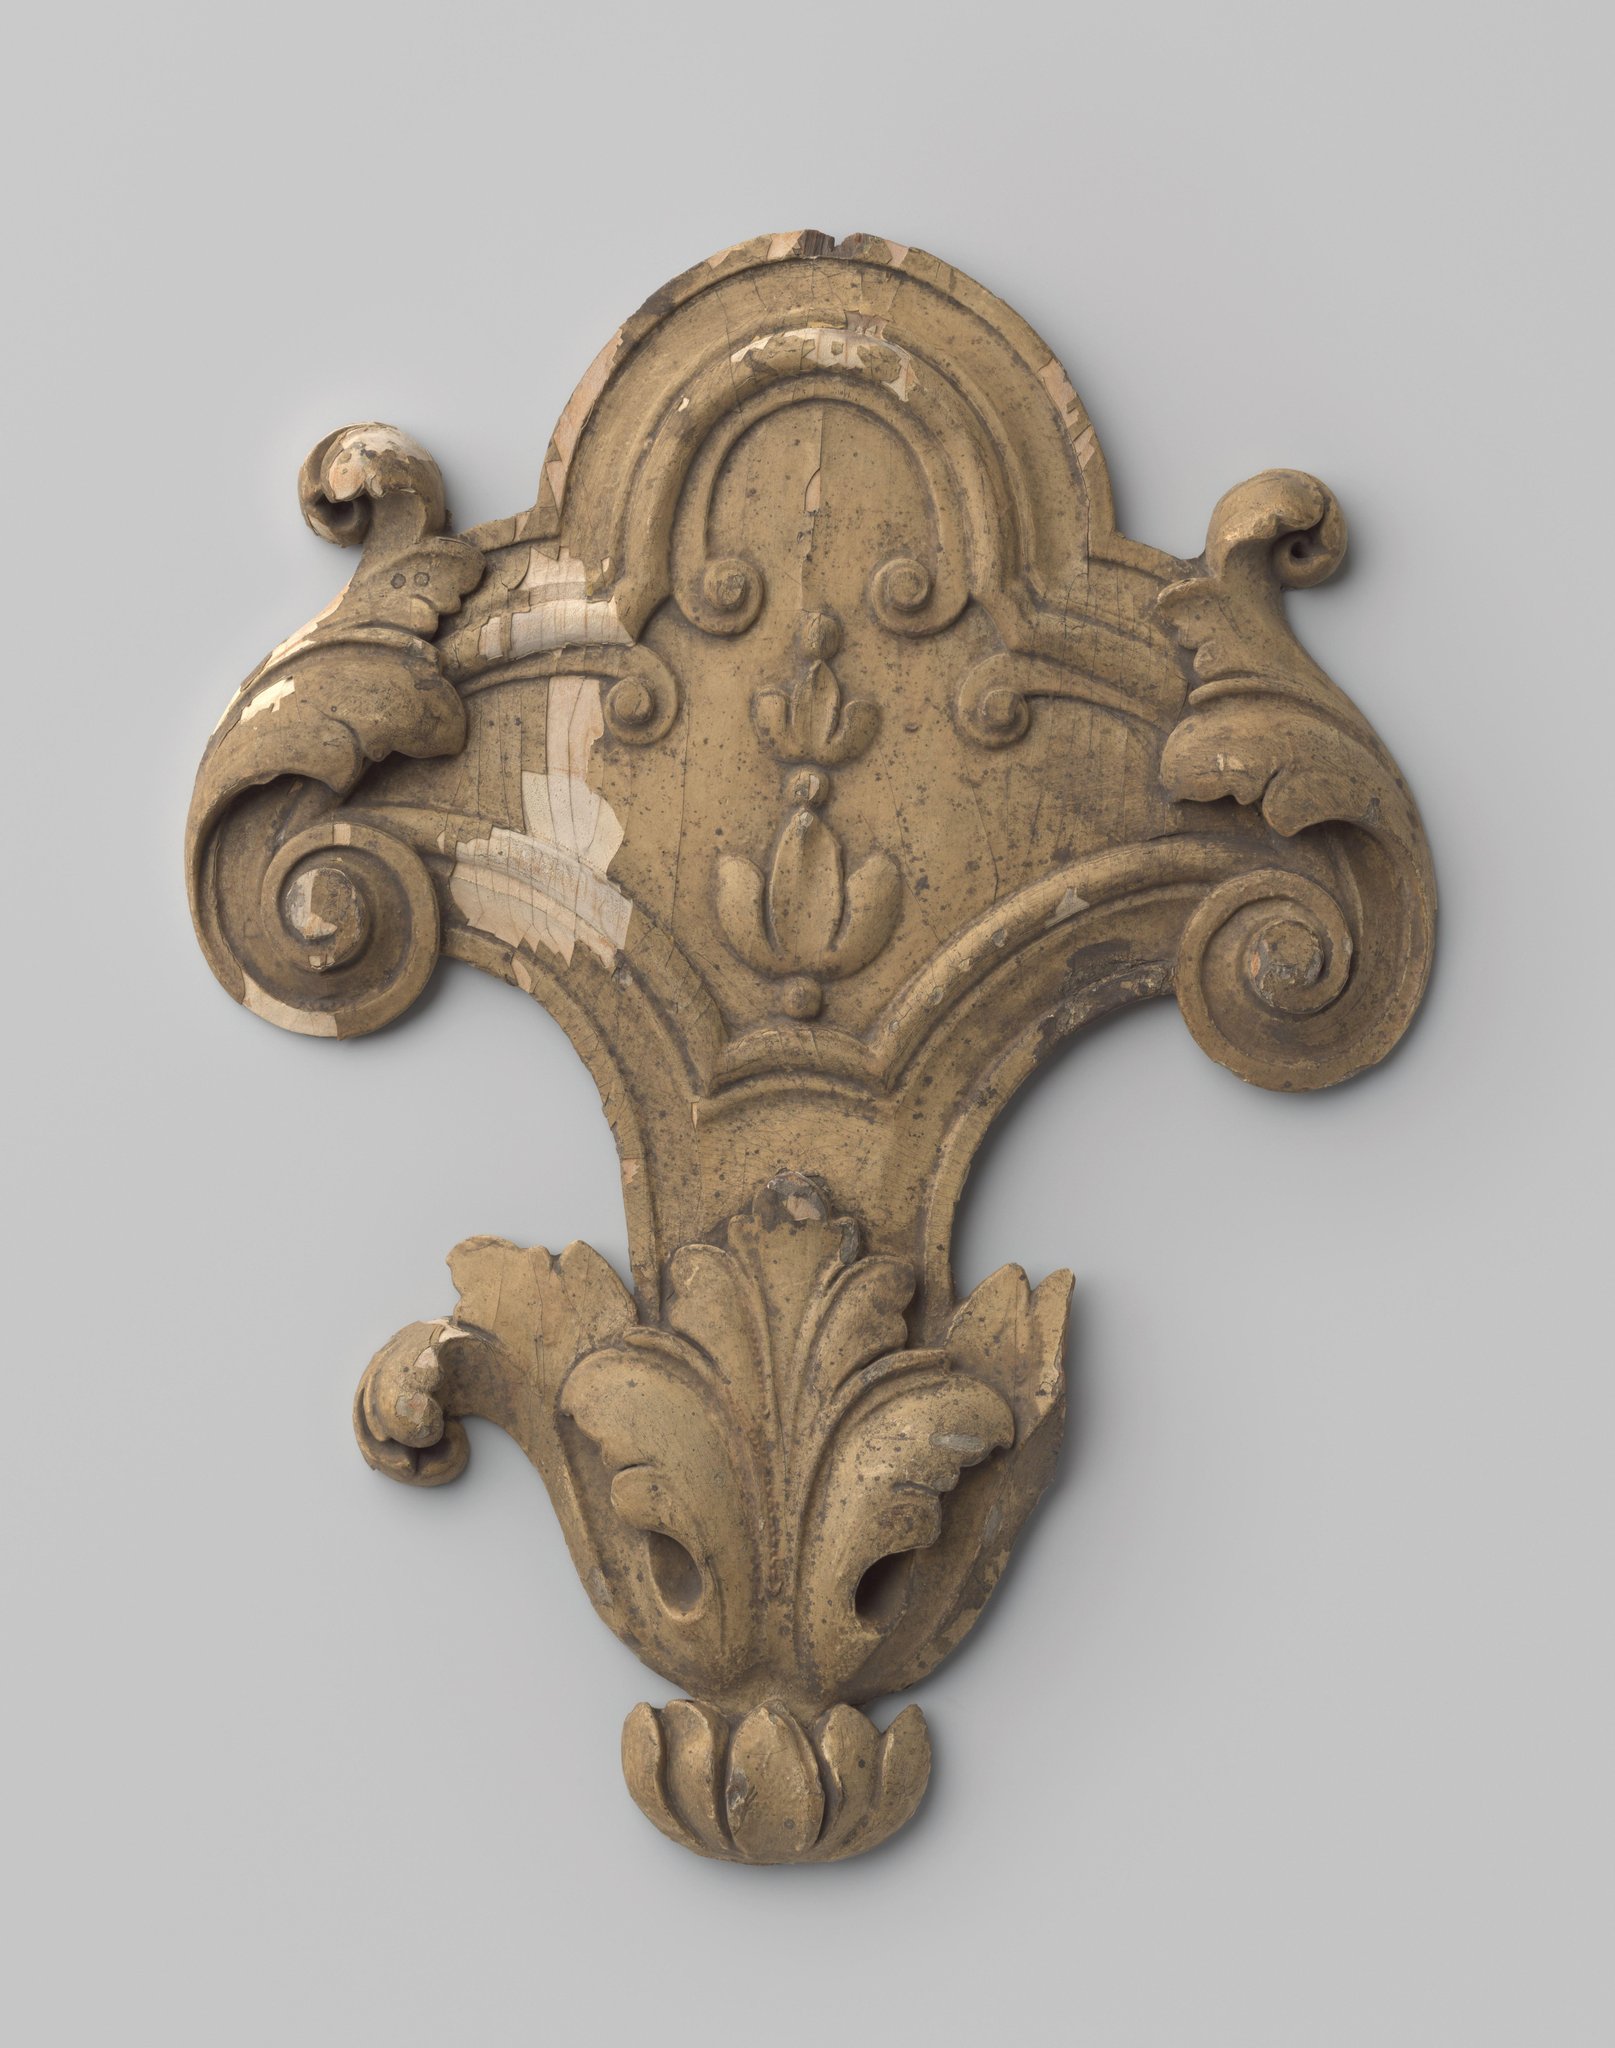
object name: decoratief object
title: Bouwfragment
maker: Anonymous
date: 1400-1950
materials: wood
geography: netherlands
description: Decoratie van lindenhout (?) opgesiert met krullen en acanthusbladeren. Het hele object heeft de vorm van een gestileerde Franse lelie.